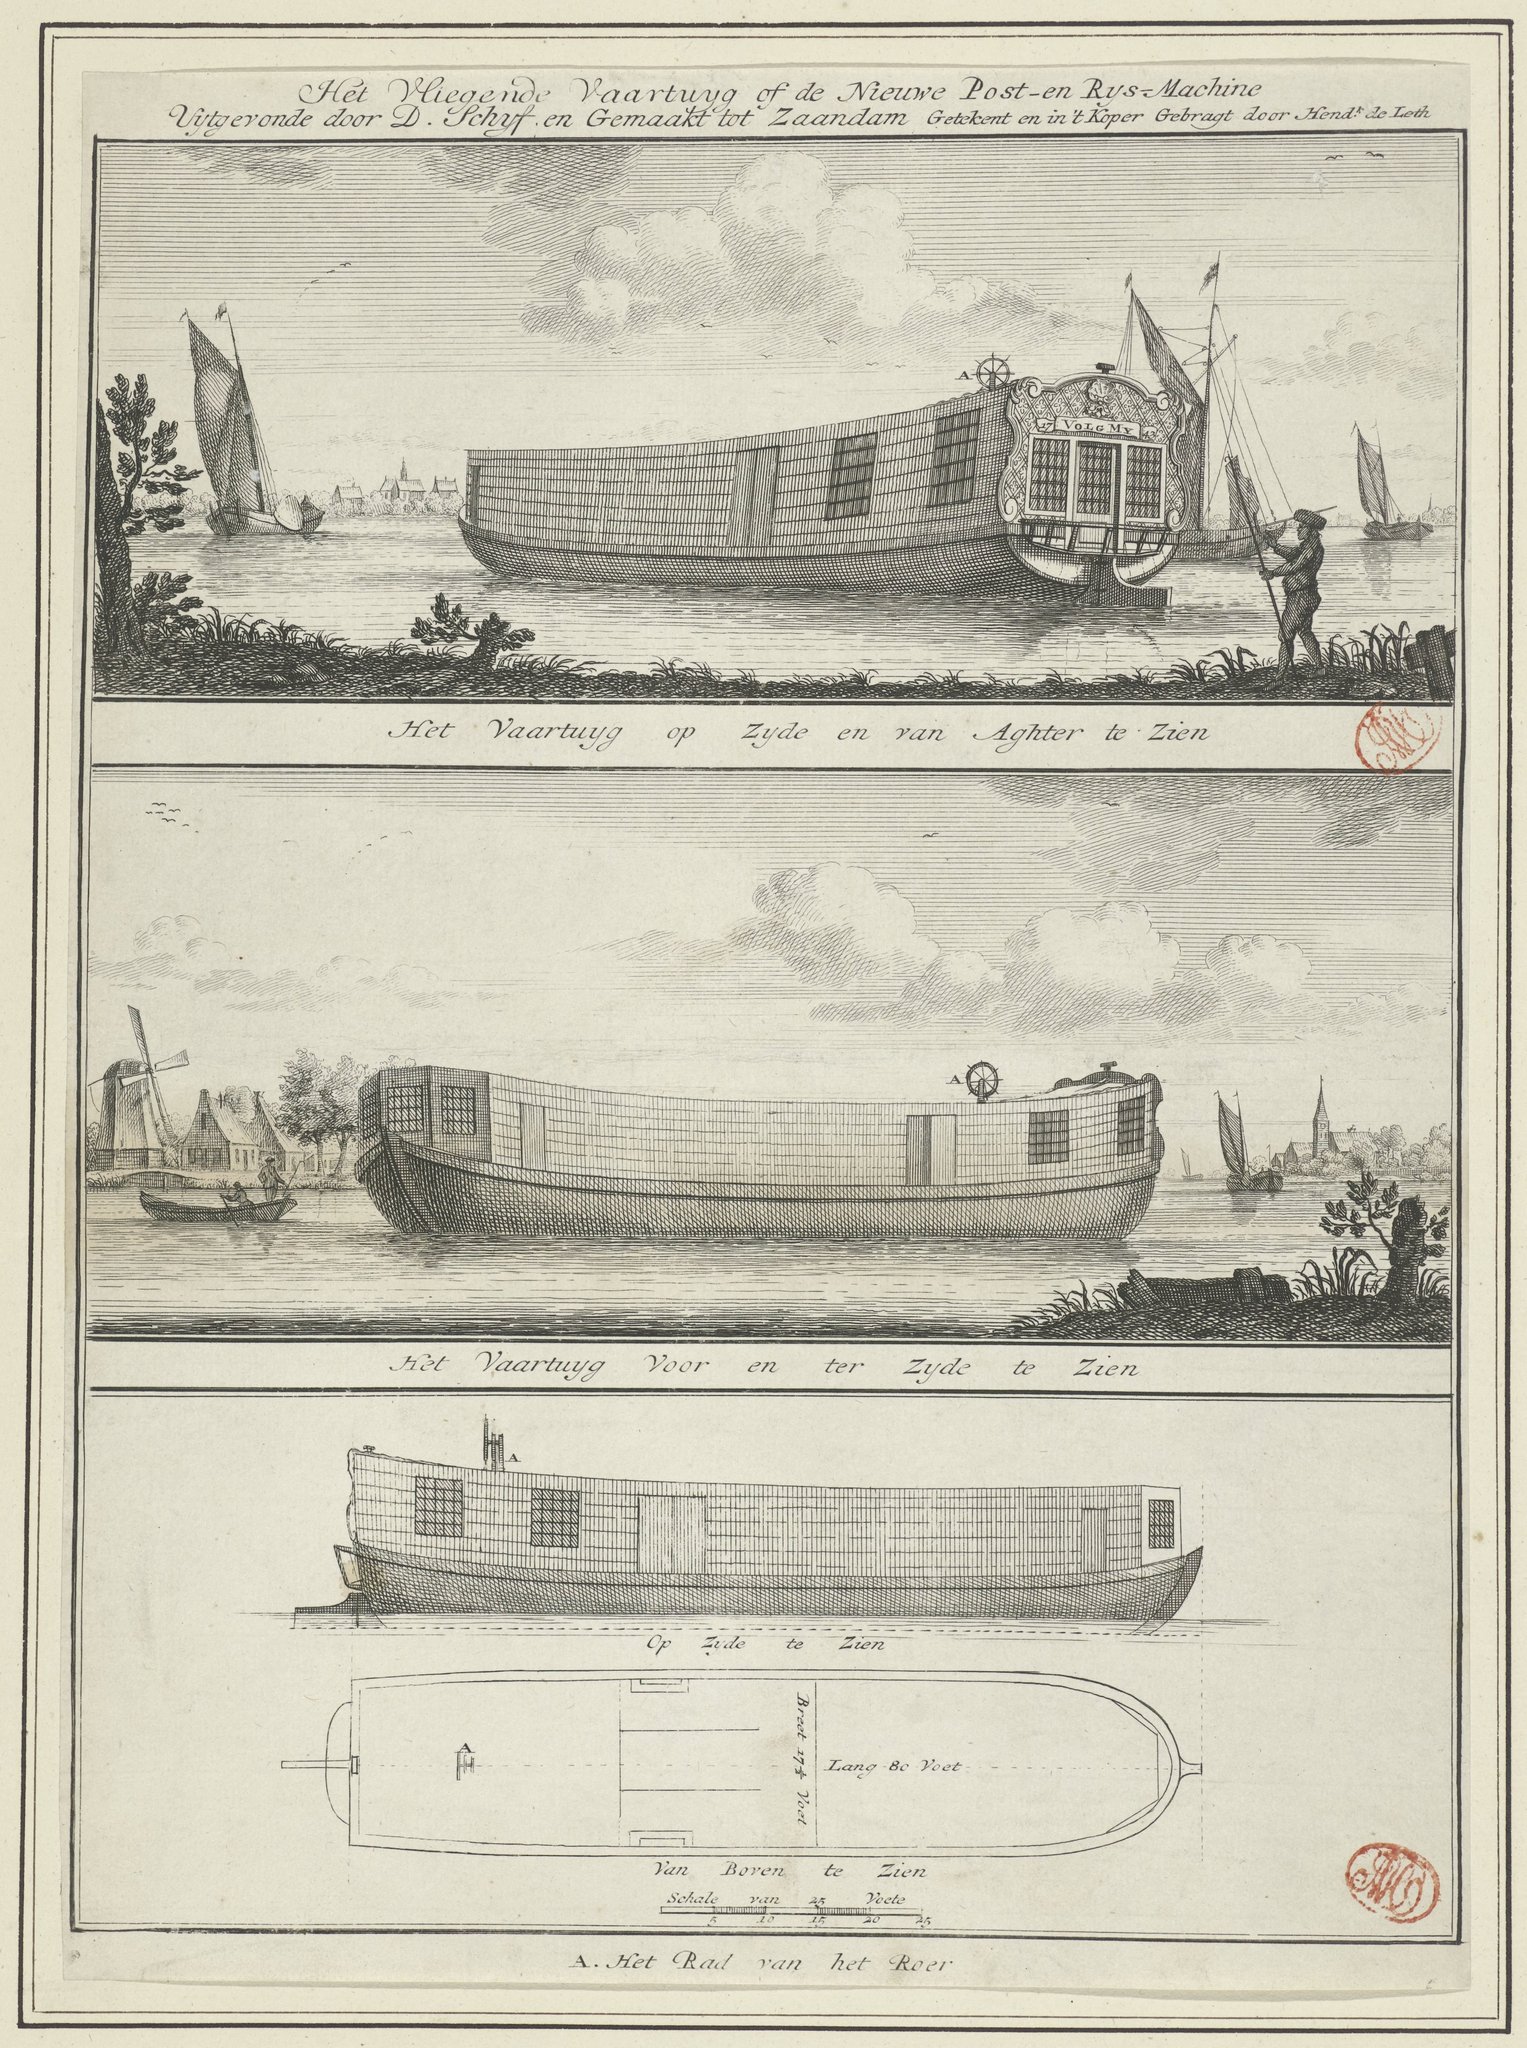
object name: print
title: Het Vliegende Vaartuig van Daam Schijf, 1743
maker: hendrik de leth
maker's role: draughtsman, print maker, publisher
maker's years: 1703-1766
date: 1743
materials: paper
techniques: engraving, etching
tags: ships (in general) (+ propulsion of vehicle, ship, etc. by animals), invention, discovery ~ science and technology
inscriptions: collector's mark: Lugt 195, collector's mark: Lugt 2228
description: Blad met drie voorstellingen van het zogenaamde Vliegende Vaartuig, een vaartuig genaamd Volg My, dat zonder zeilen grote snelheden zou moeten halen, een uitvinding van Zaandamse kruidenier Daam Schijf. Op 20 juni 1743 werd het schip, met een door vijf paarden aangedreven rad verborgen in het ruim, in de Zaan te water gelaten waar het zonk.